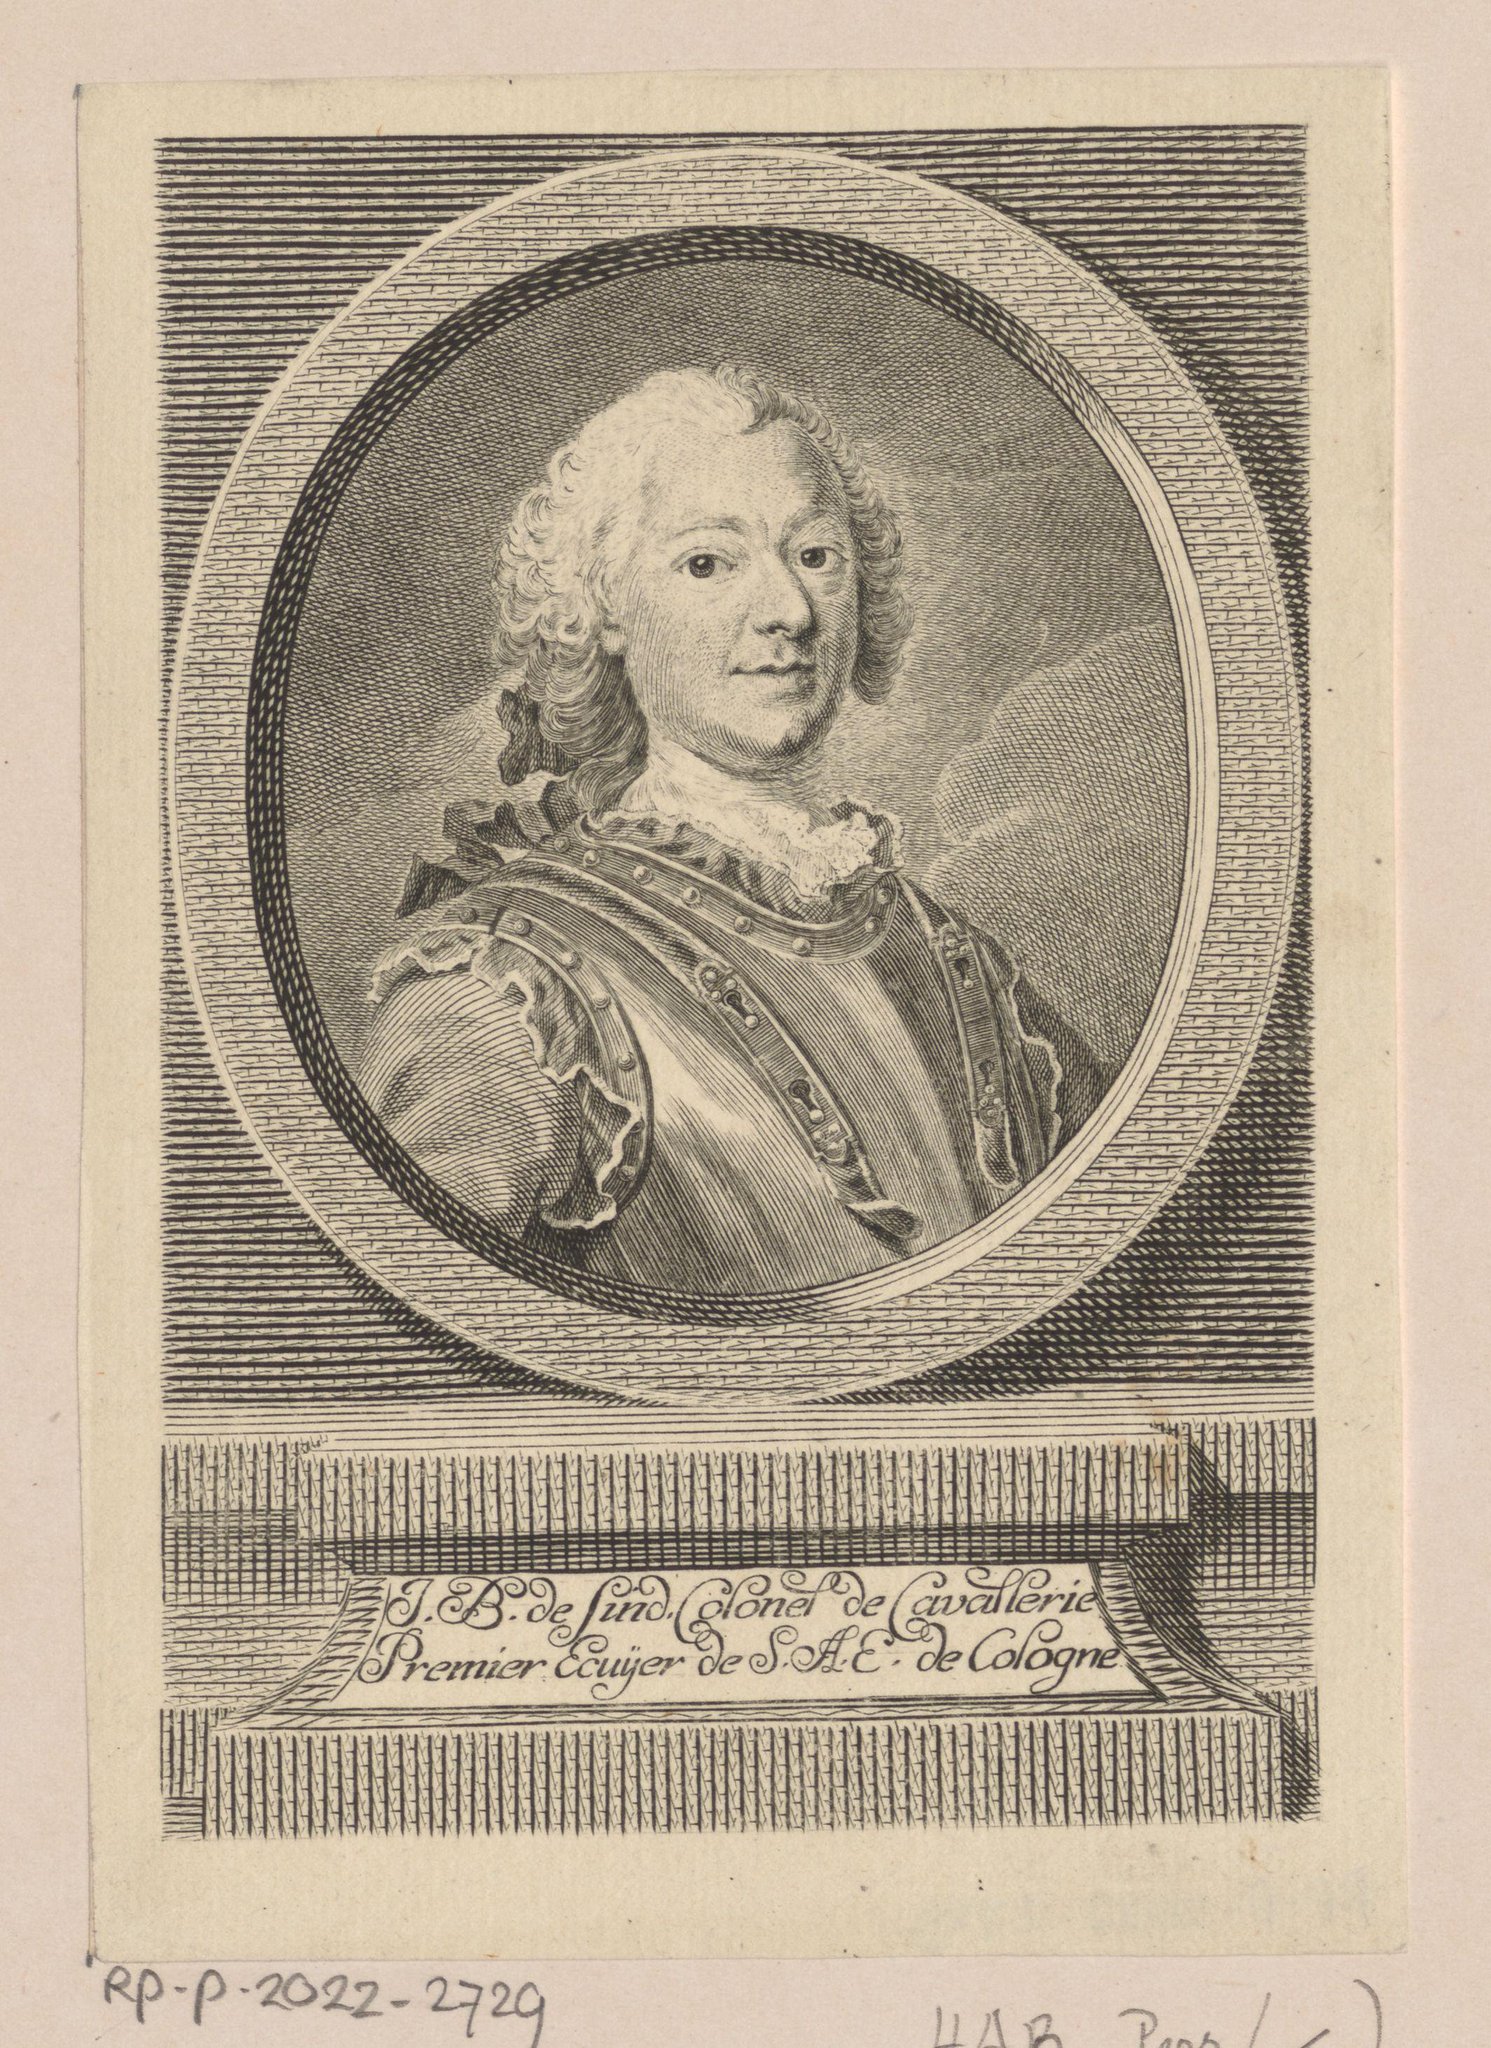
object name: print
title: Portret van Johann Baron von Sind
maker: Anonymous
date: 1739-1799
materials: paper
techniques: engraving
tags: shield-bearer, squire, historical persons, veterinarian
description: Met tweeregelig onderschrift in het Frans.